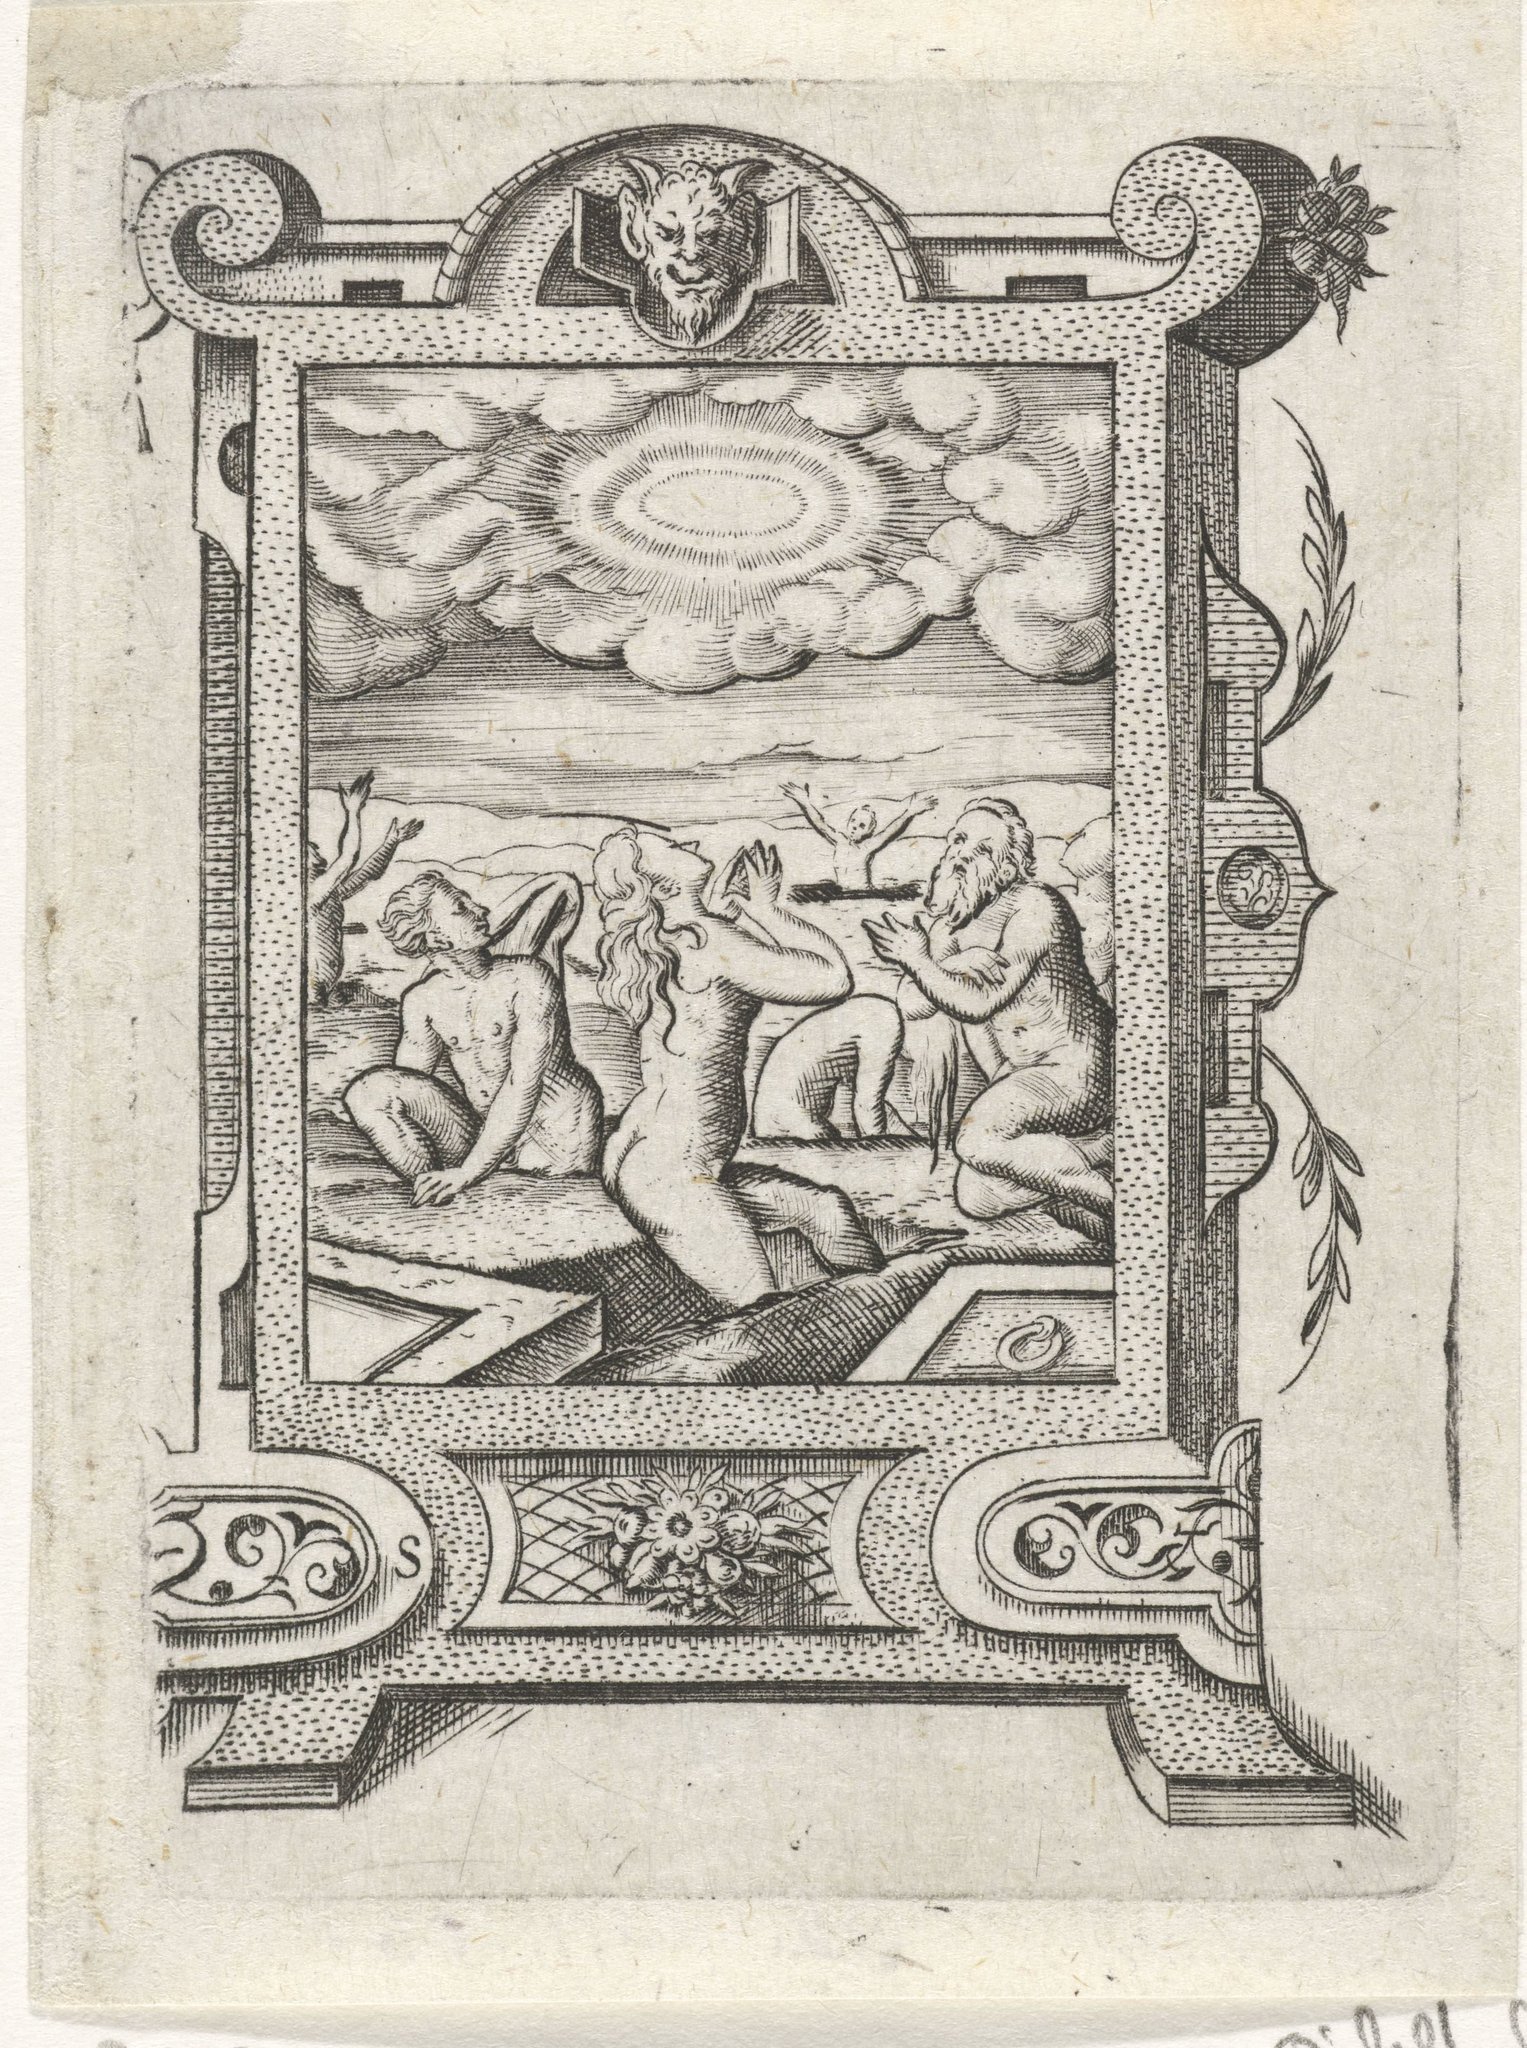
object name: ornament print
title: Opstanding der doden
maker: virgilius solis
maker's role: draughtsman, print maker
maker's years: 1514-1562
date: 1524-1562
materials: paper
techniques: engraving